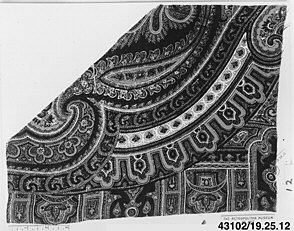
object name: sample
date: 1830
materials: wool